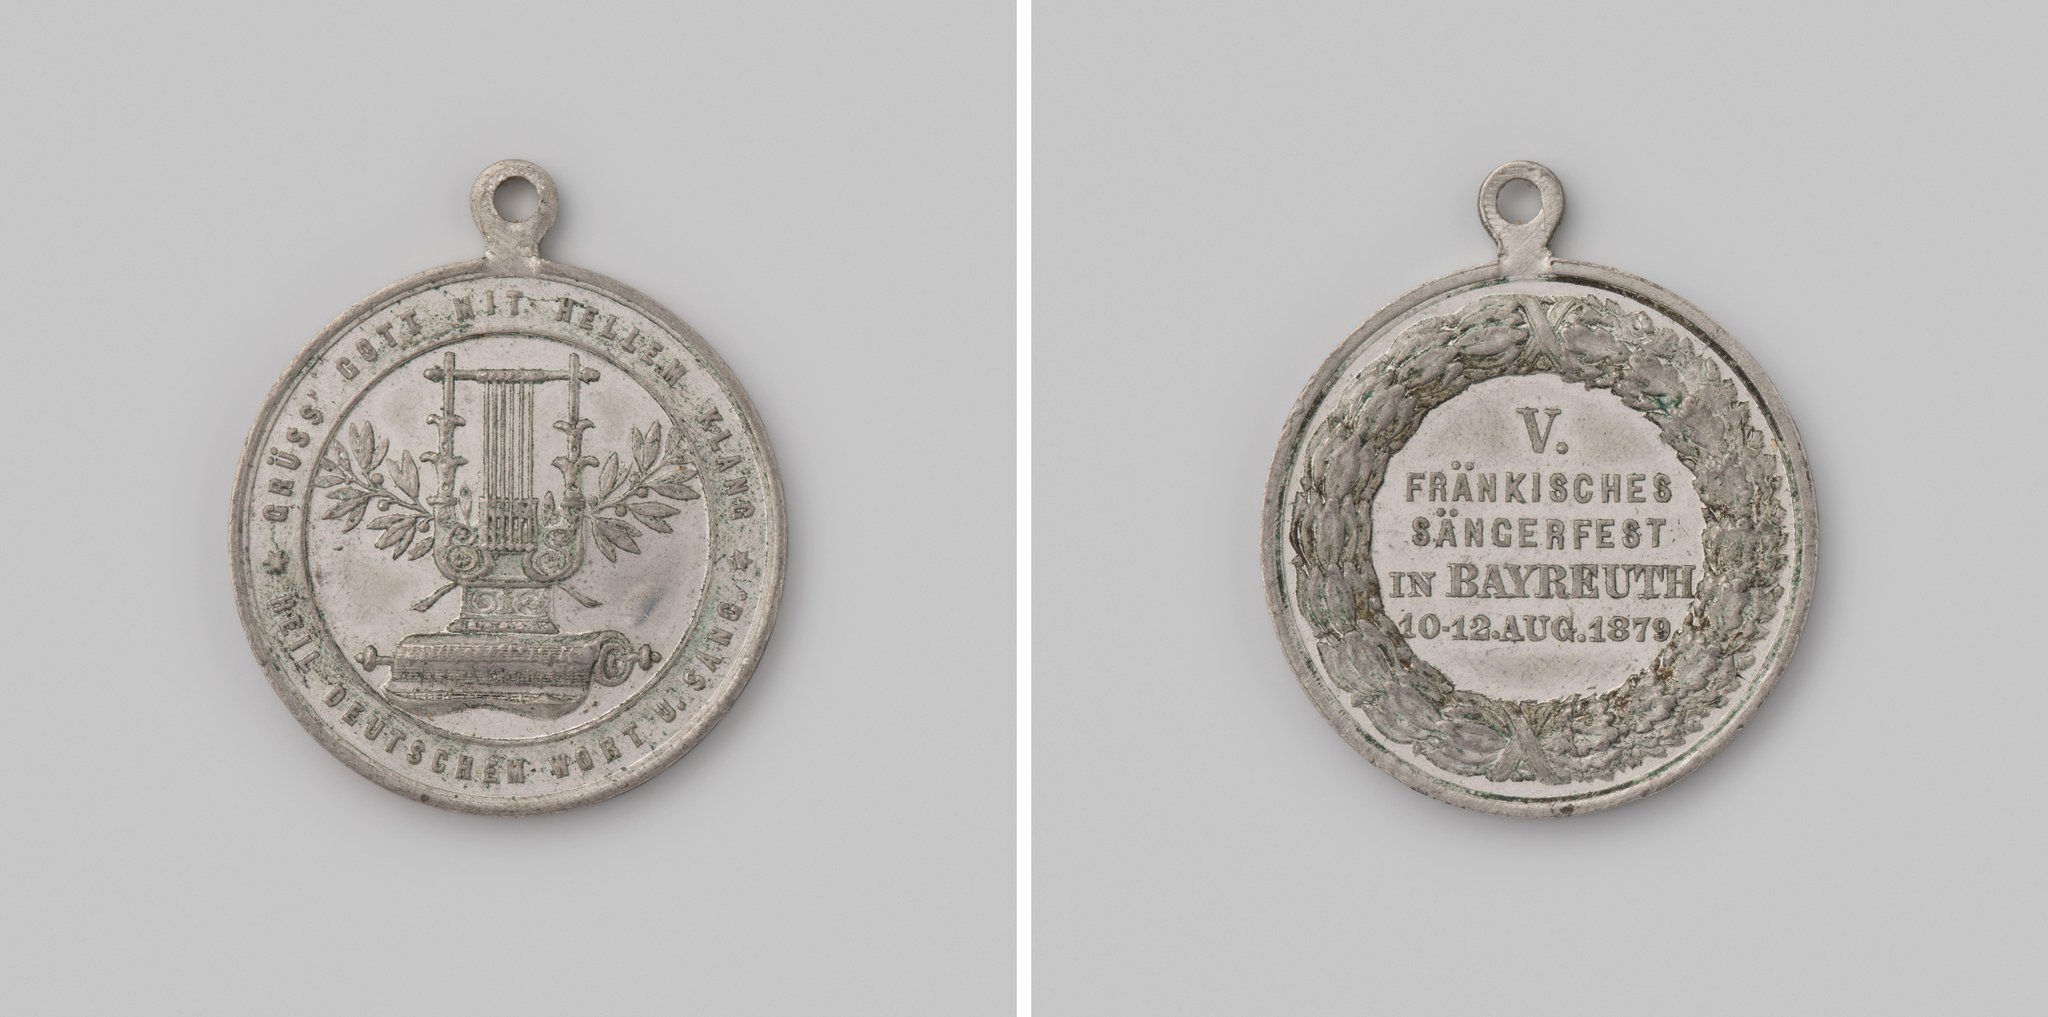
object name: history medal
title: Vijfde Frankische Zangersfeest te Bayreuth 1879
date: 1879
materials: tin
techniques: striking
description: Tinnen penning met draagoog, op de voorzijde een muziekrol, een lier en lauwertakken, met omschrift, op de keerzijde vijf regels tekst binnen een zware eikenkrans